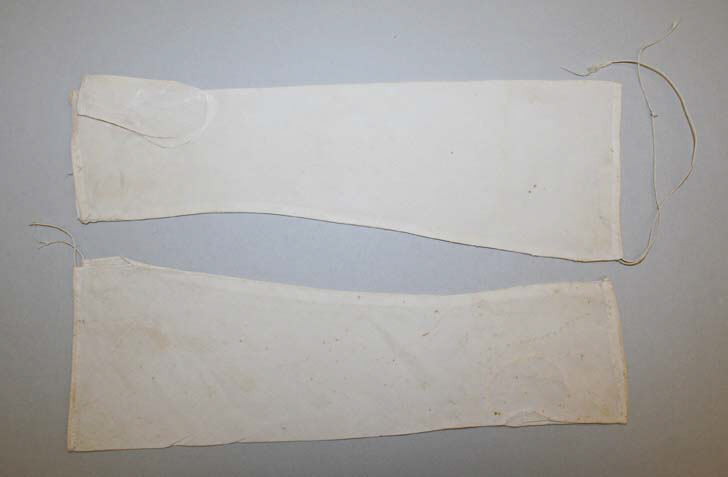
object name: mitt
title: Mitts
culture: american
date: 1838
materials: linen